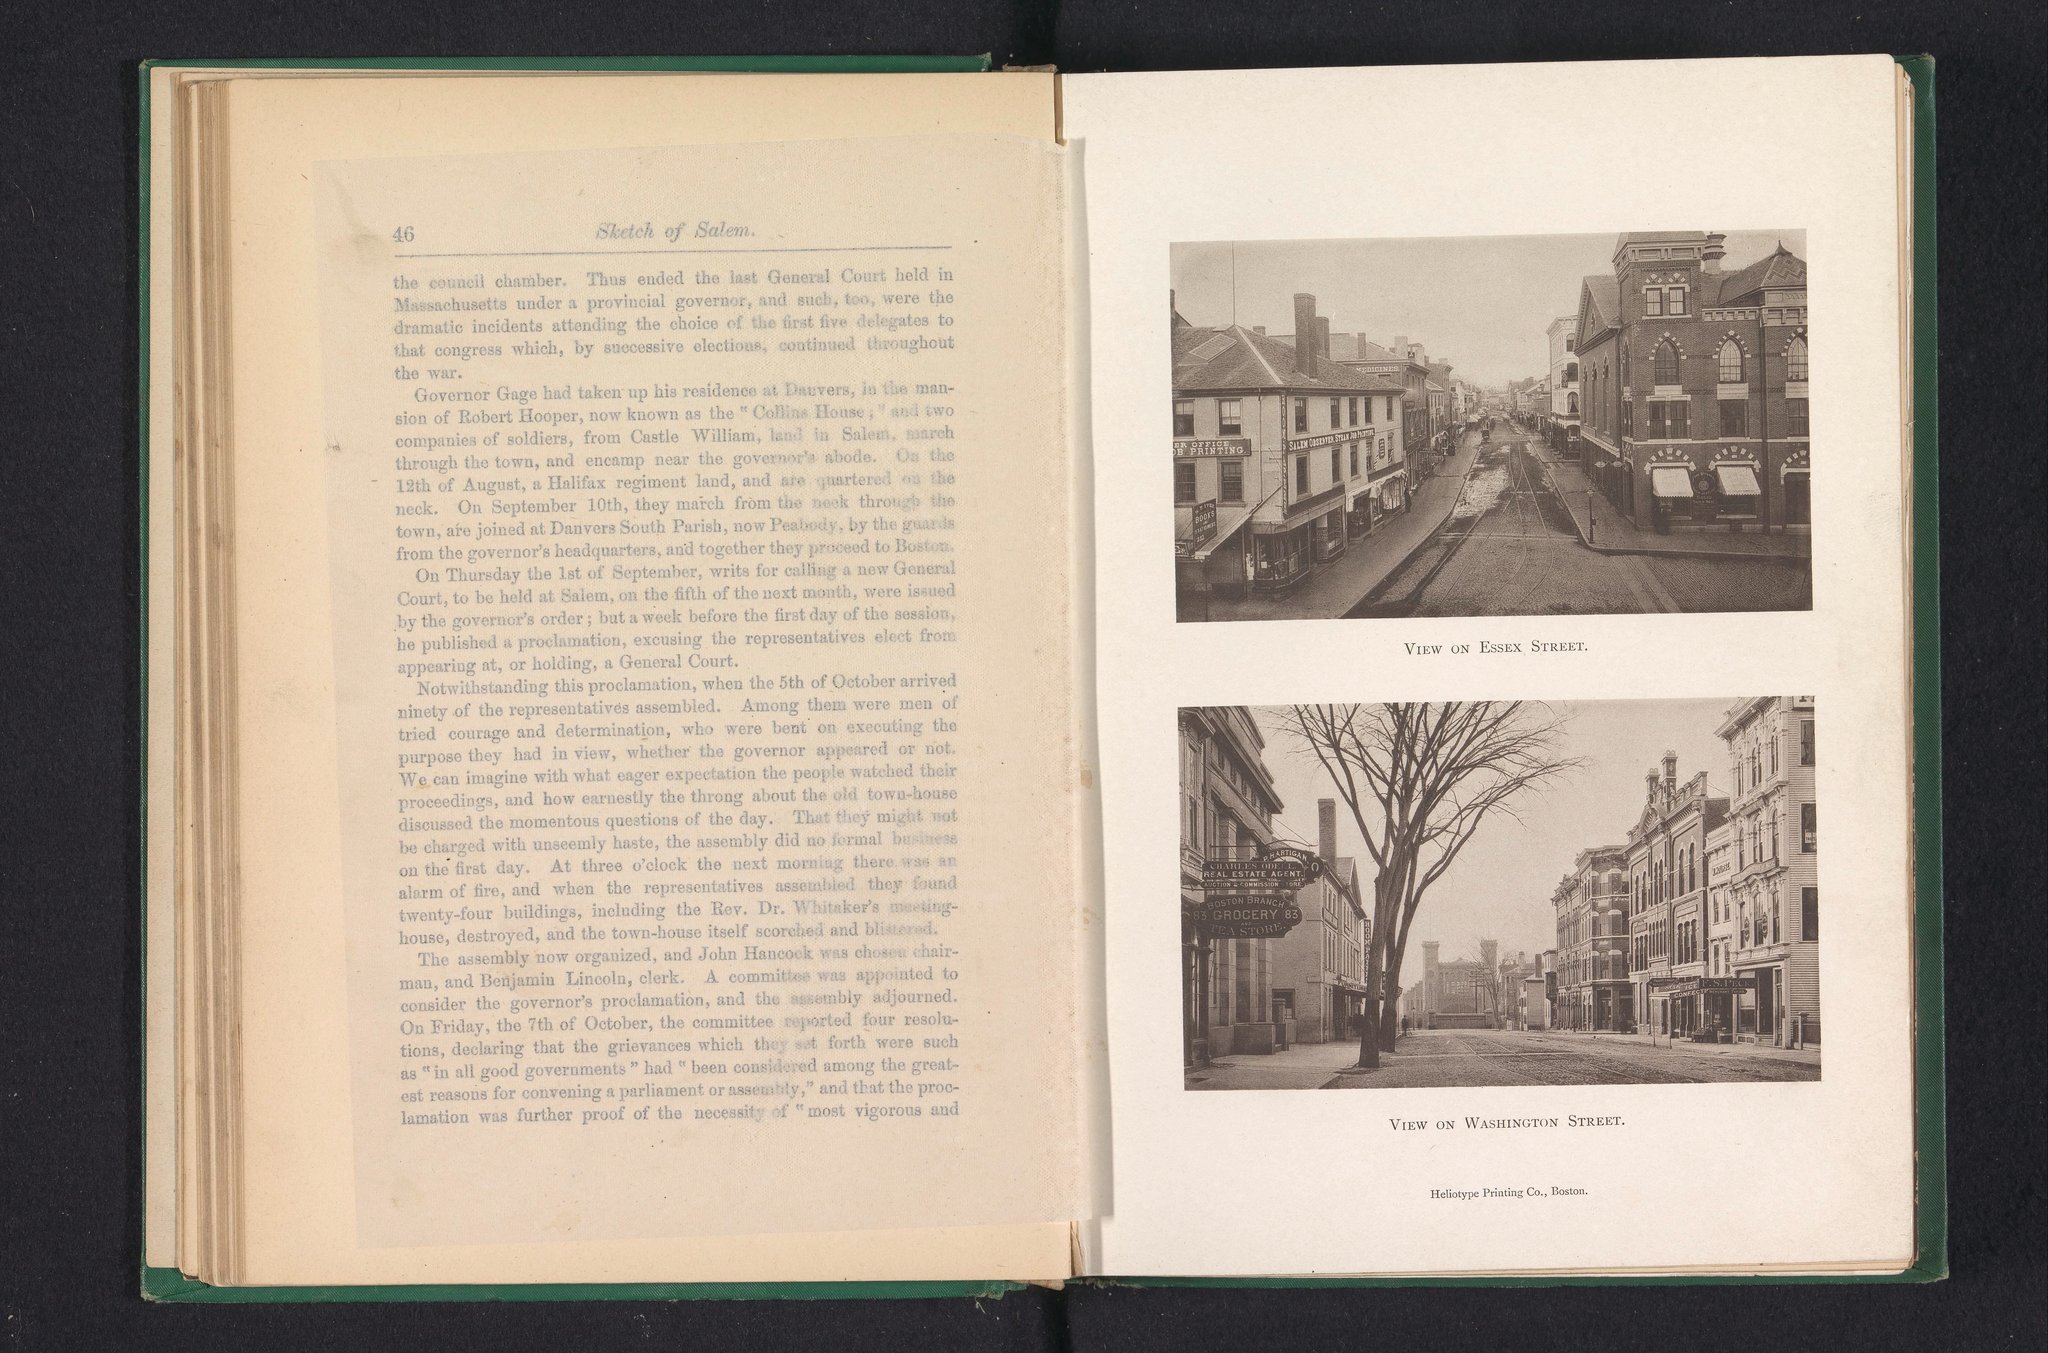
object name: photomechanical print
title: View on Essex Street. View on Washington Street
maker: Anonymous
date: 1804-1879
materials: paper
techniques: photoaquatint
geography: salem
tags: department store, supermarket, housing, street